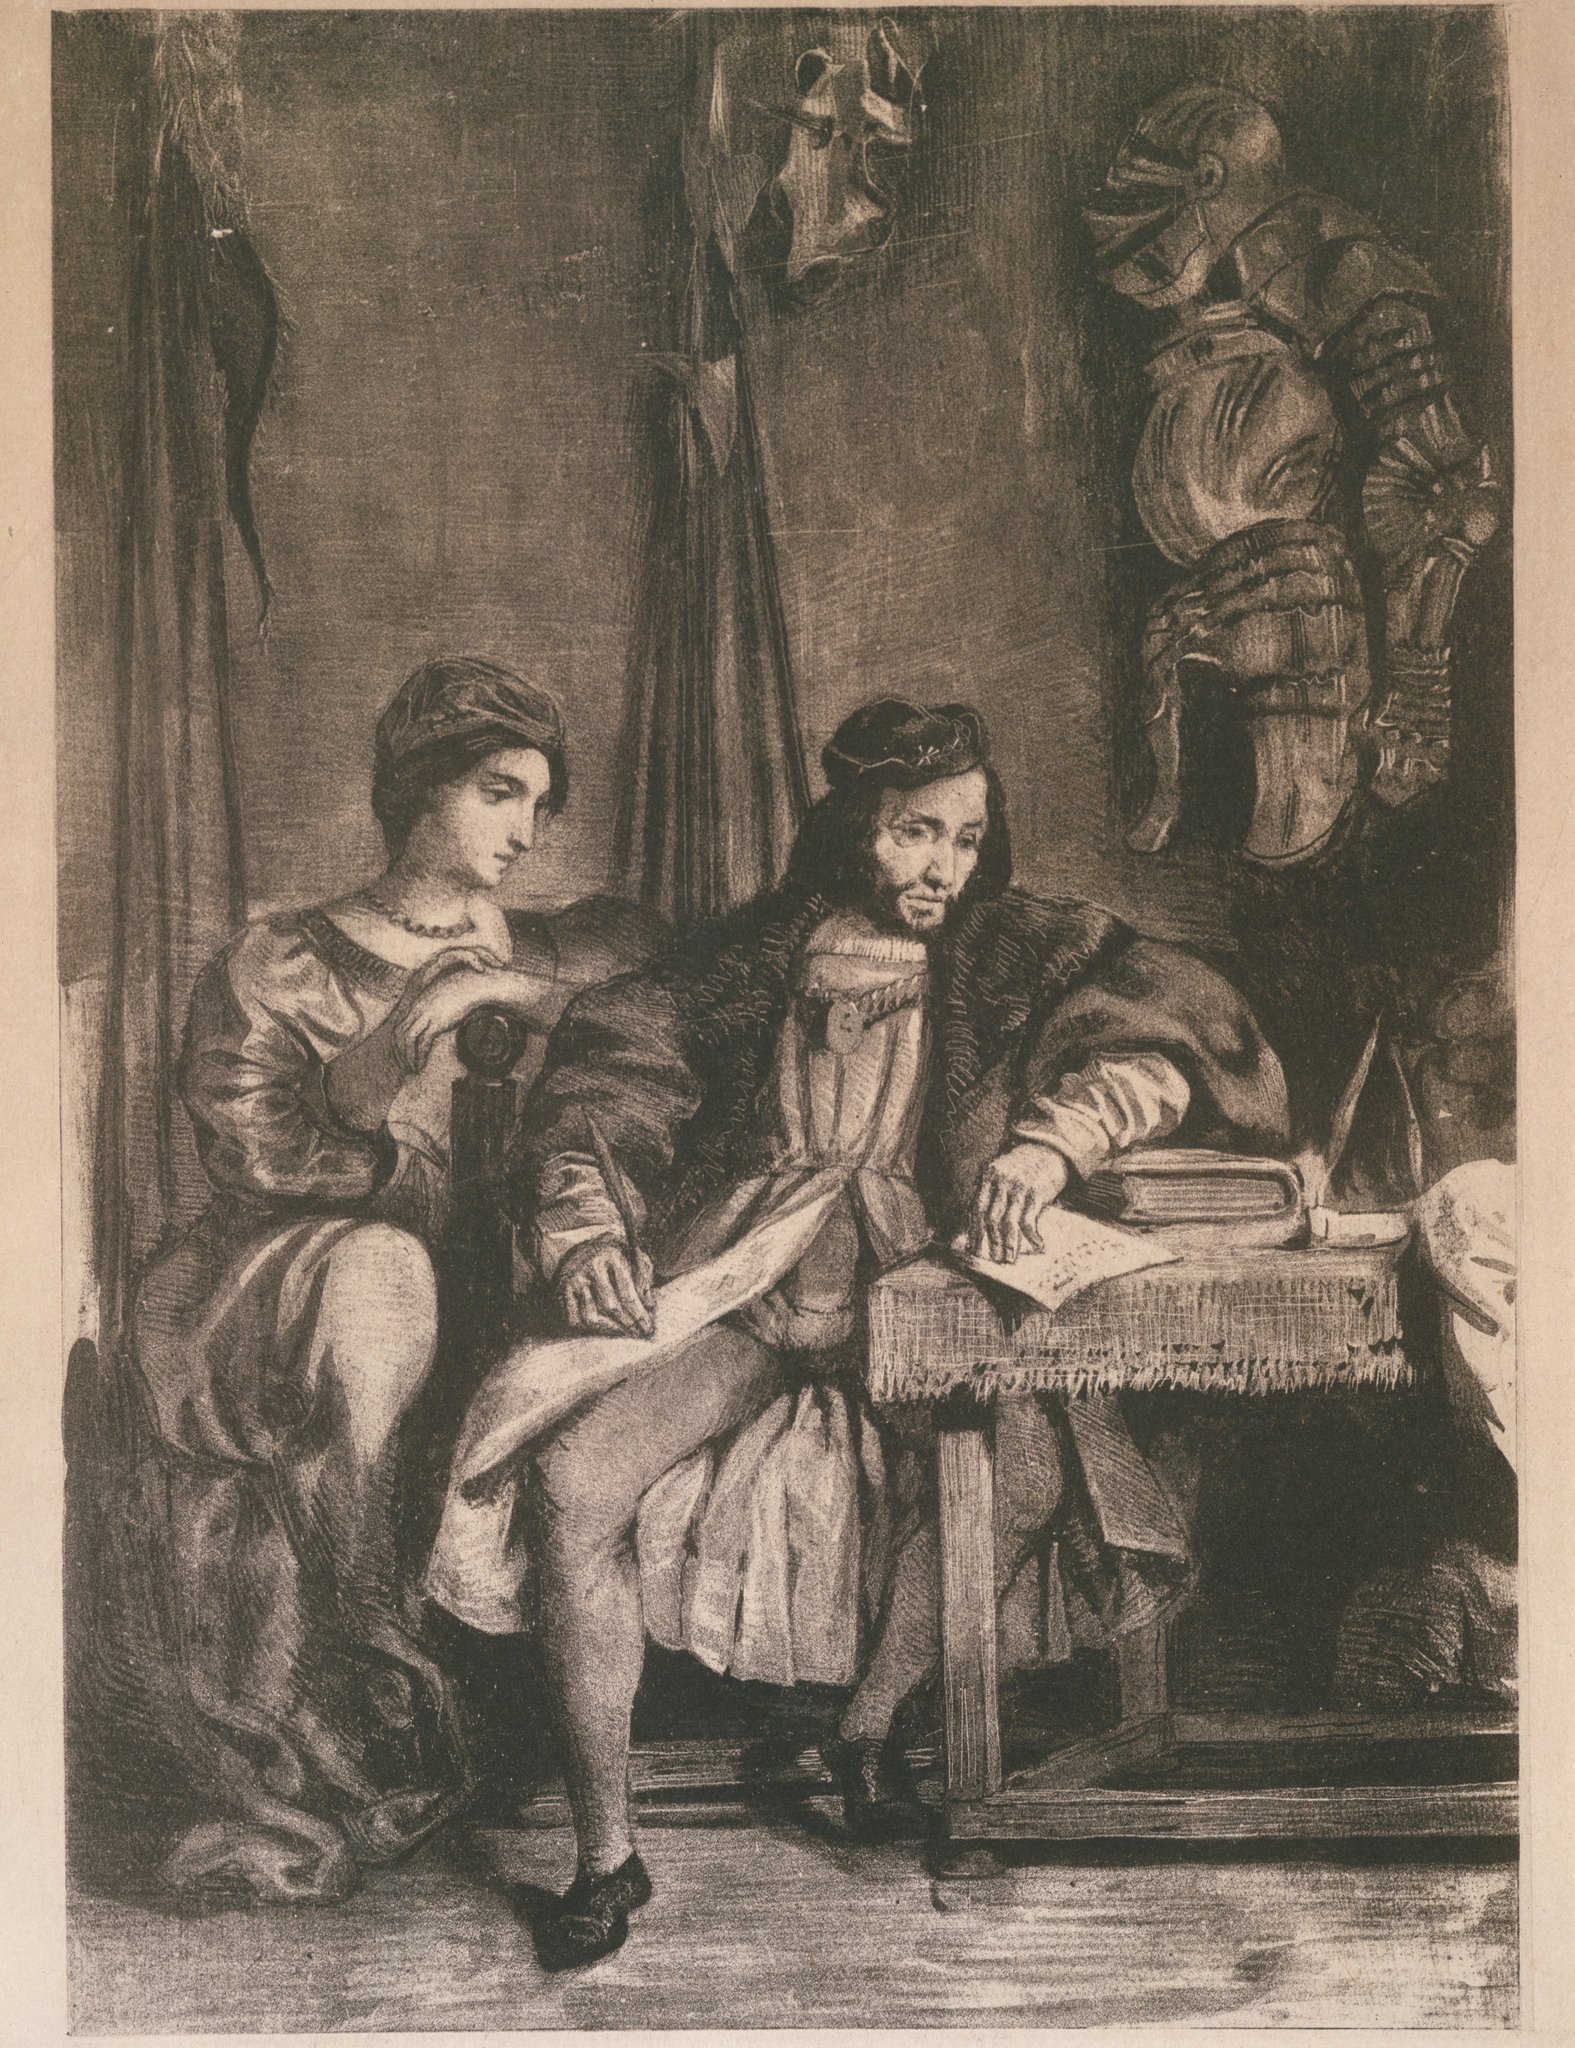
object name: print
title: Scene from Goethe's 'Götz' (Götz von Berlichingen Writing his Memoirs)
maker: eugène delacroix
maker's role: artist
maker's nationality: french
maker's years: 1798-1863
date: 1836-1863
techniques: lithograph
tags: armor,men,women,writing